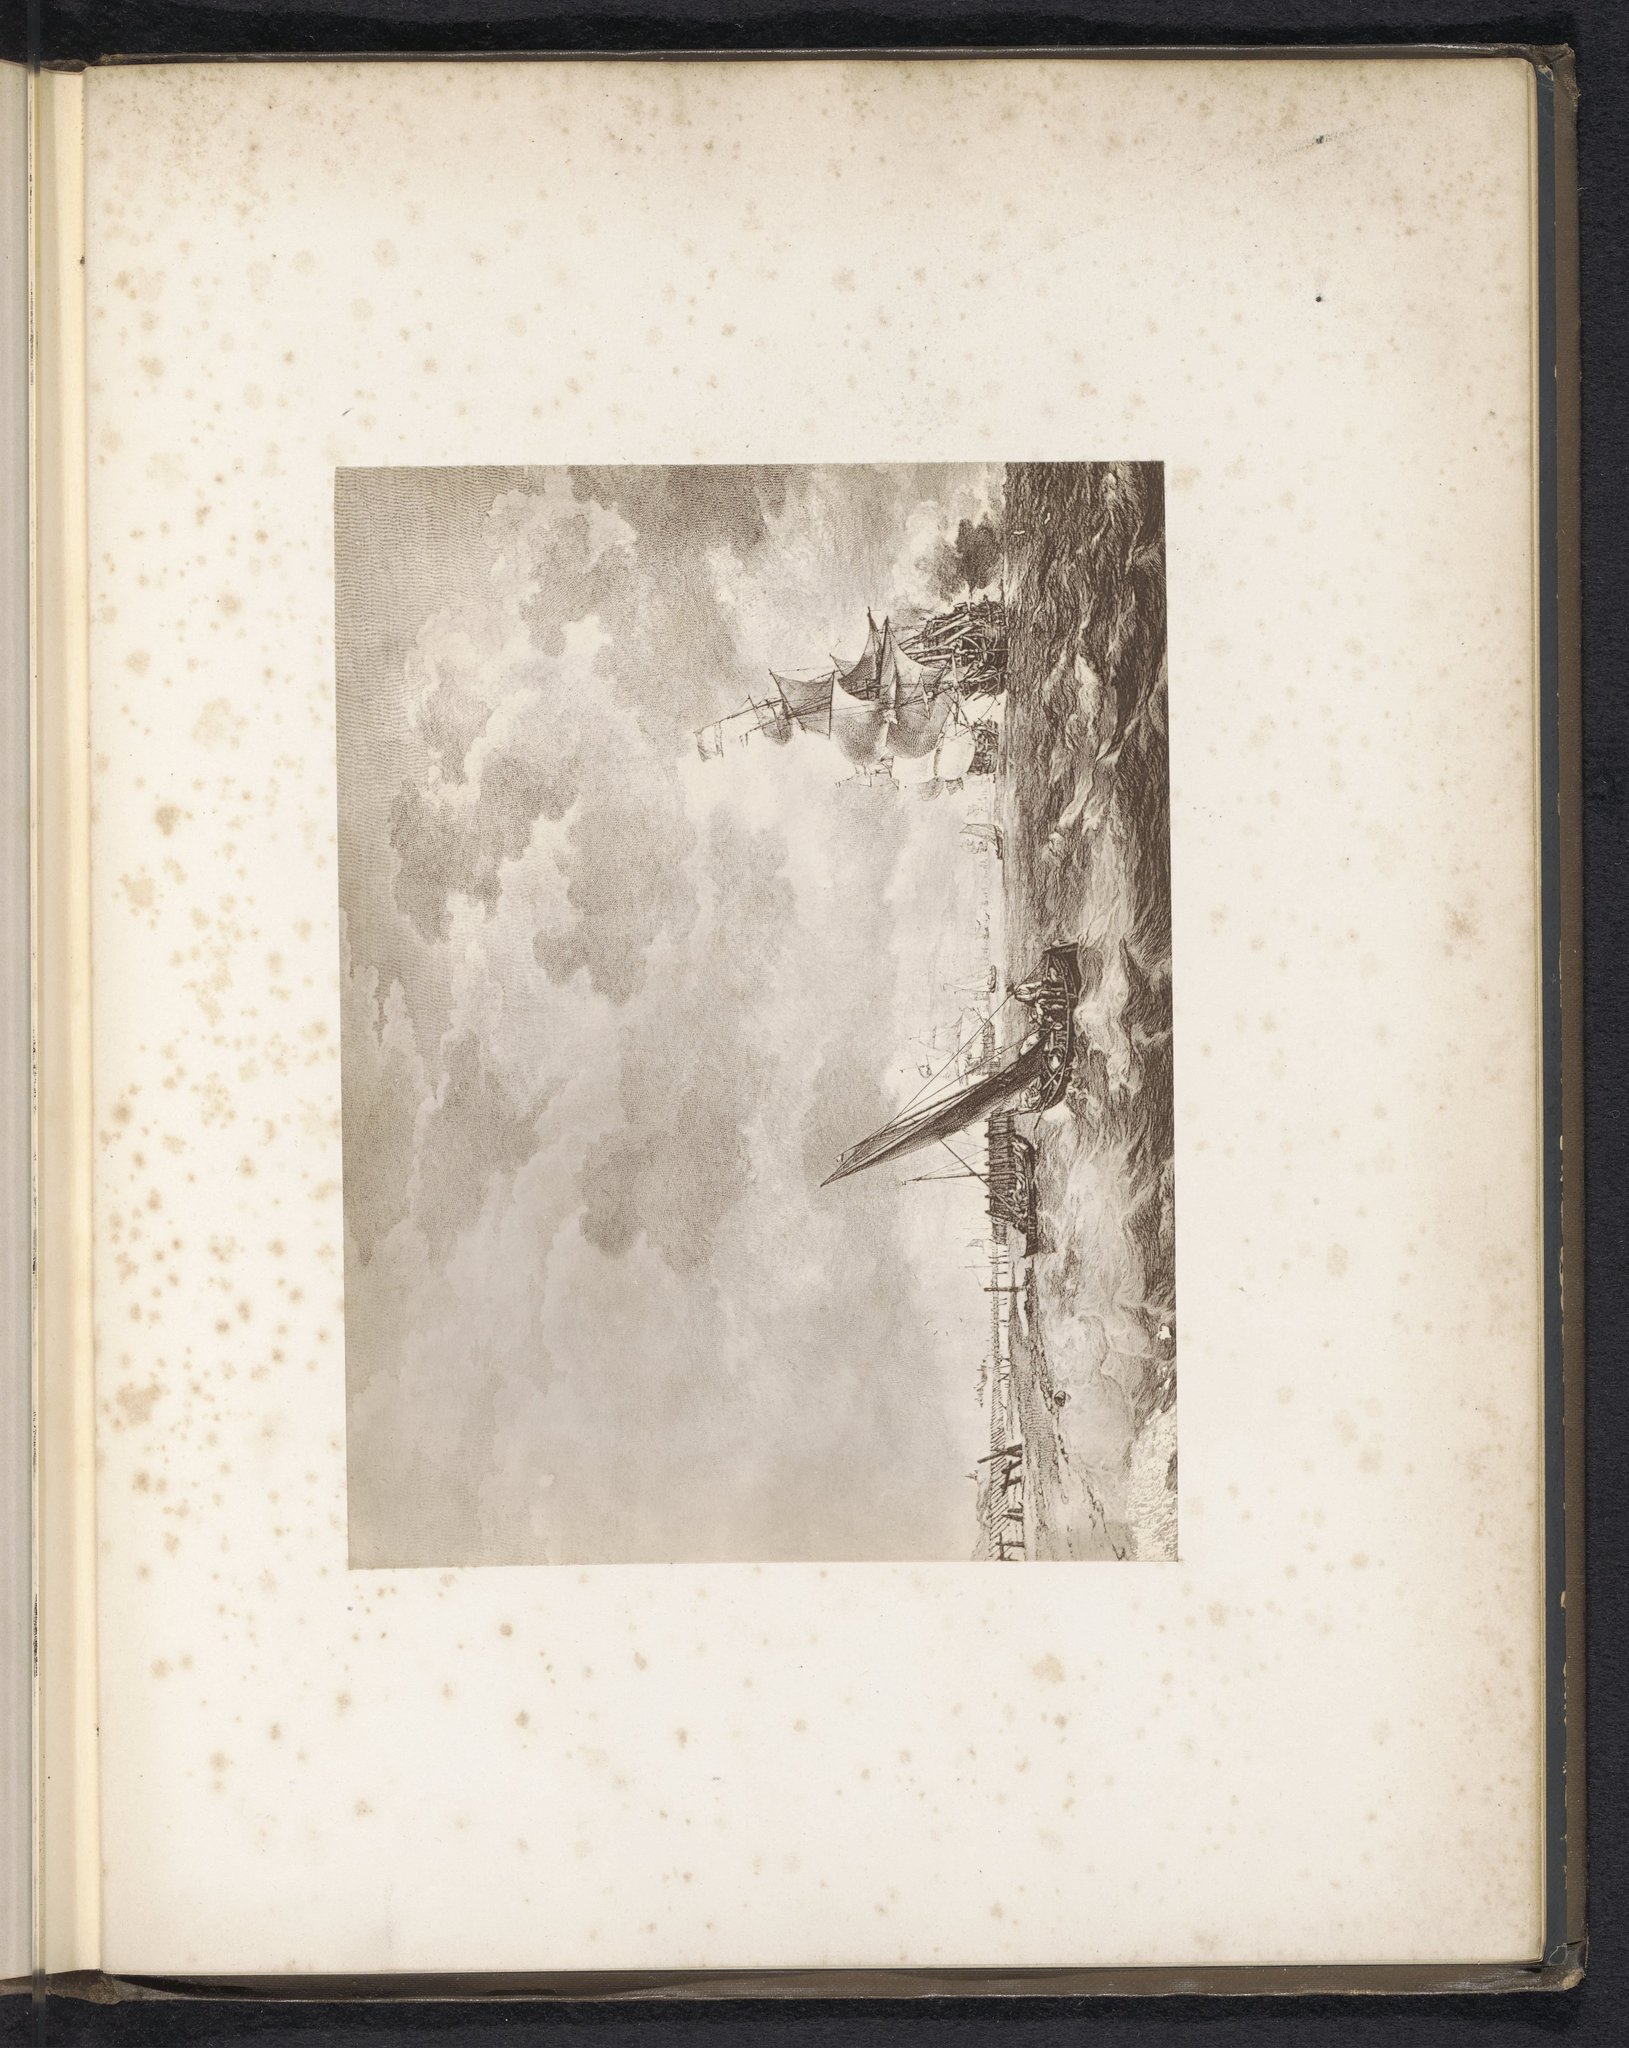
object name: photograph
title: Fotoreproductie van een prent naar een schilderij, voorstellende schepen op zee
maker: Anonymous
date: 1859-1869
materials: photographic support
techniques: albumen print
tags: ships (in general), sea